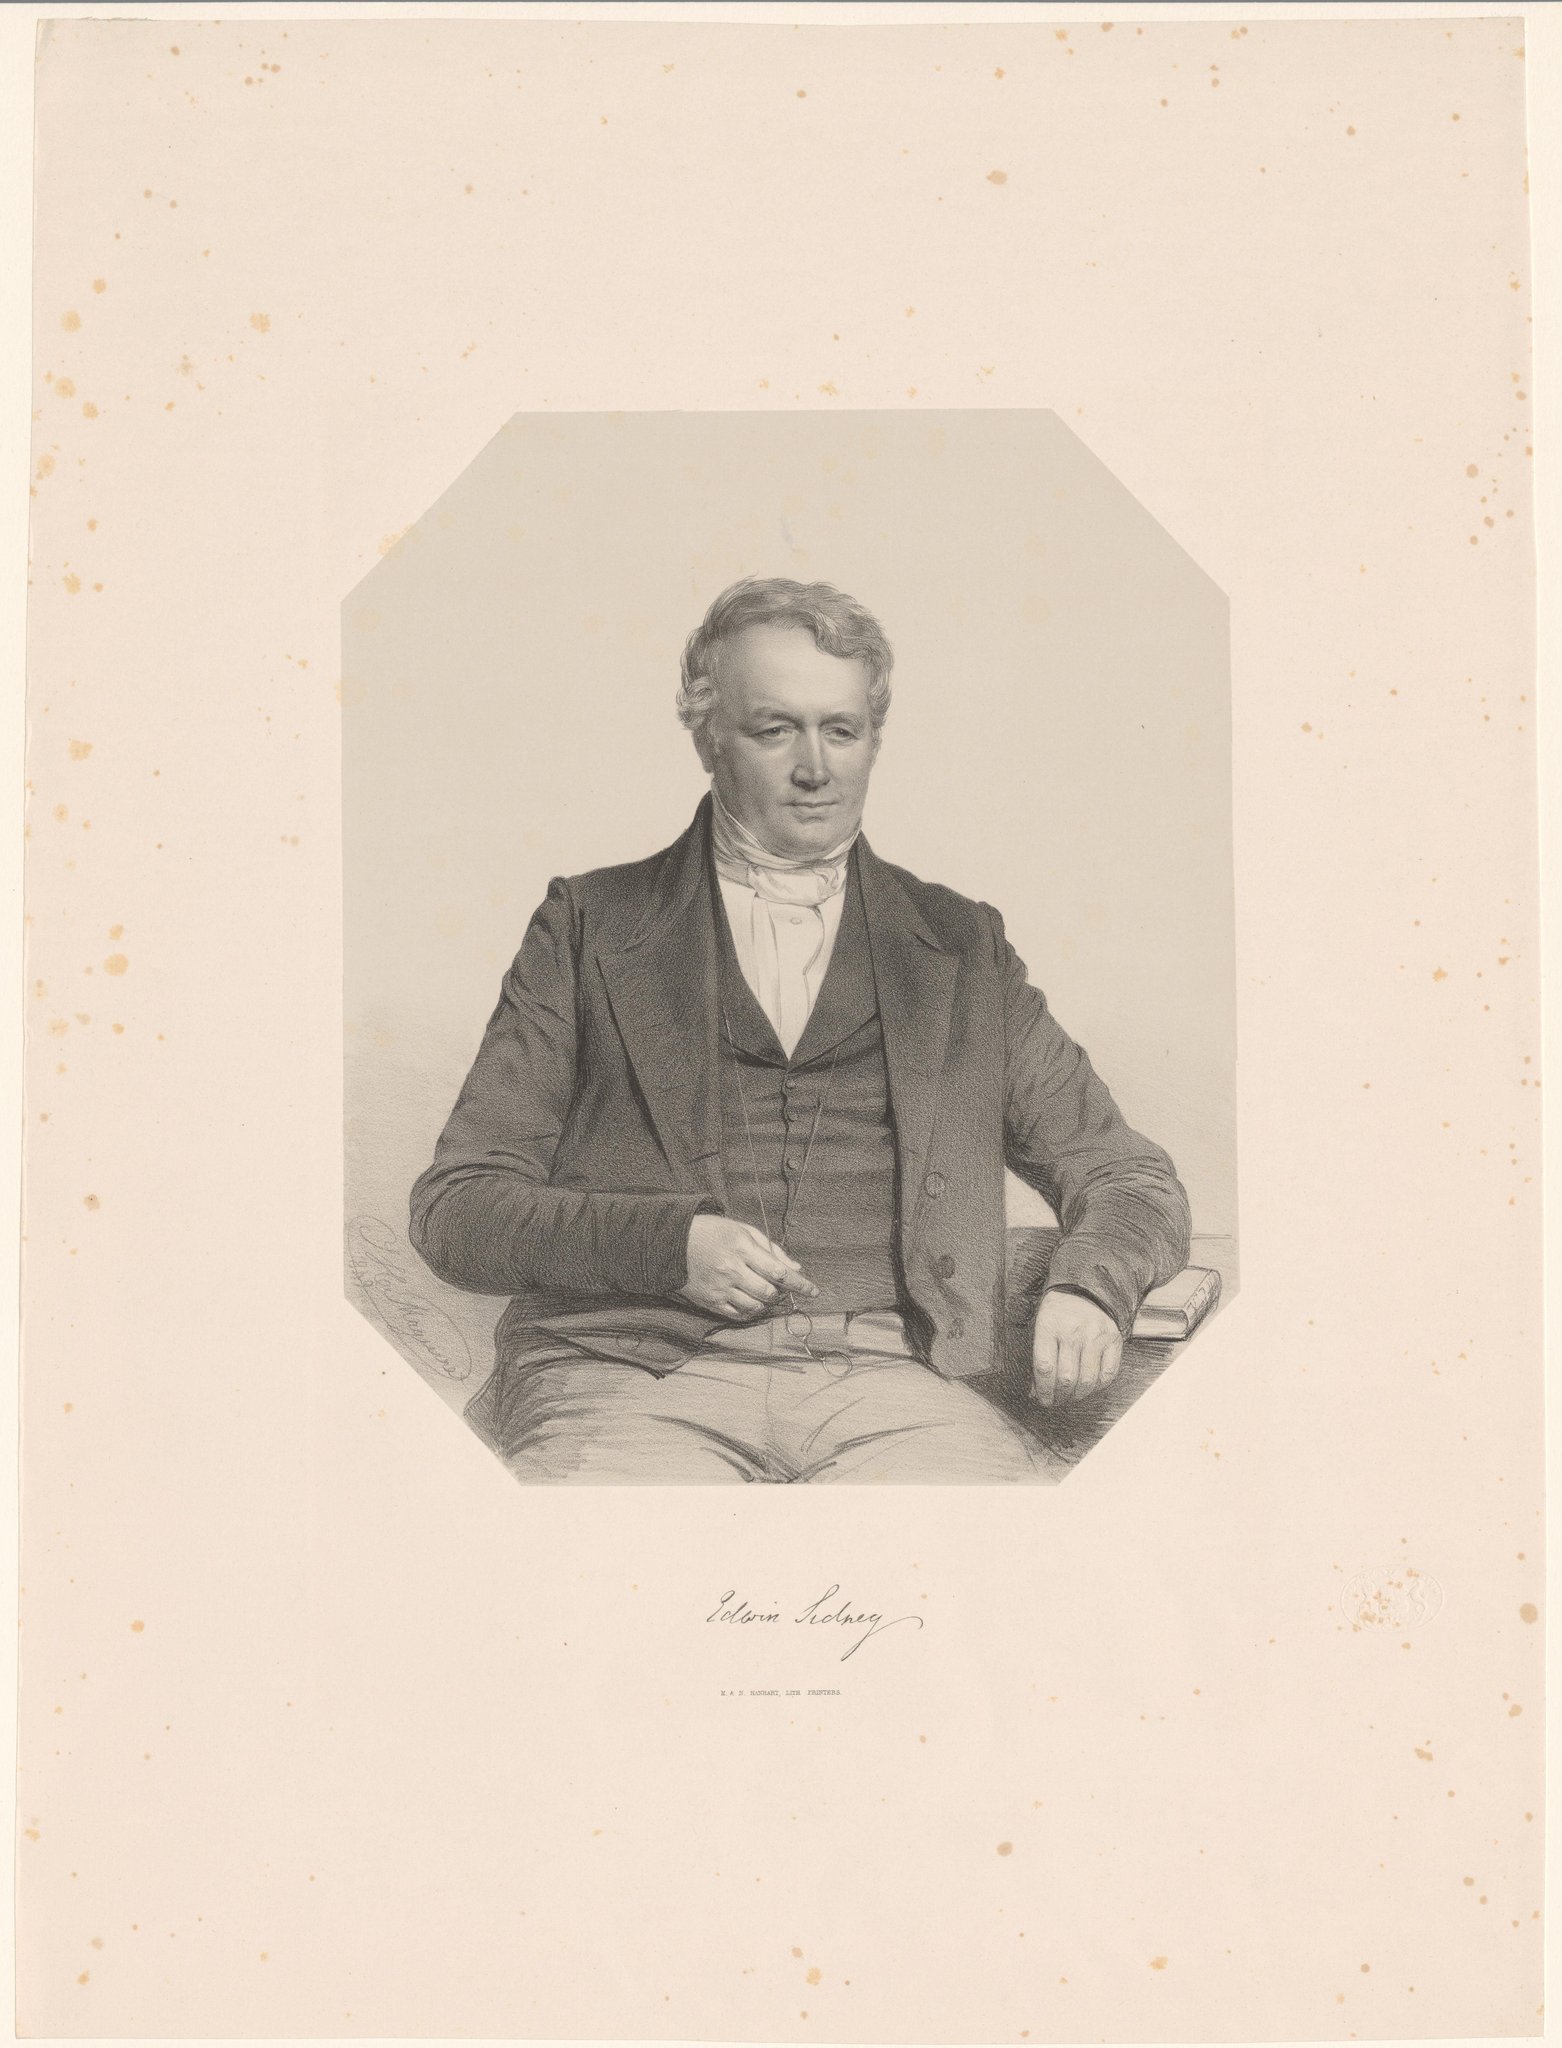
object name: print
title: Portret van Edwin Sidney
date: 1852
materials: paper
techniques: lithograph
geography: london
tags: eyeglasses, spectacles, adult man, historical persons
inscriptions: collector's mark: Lugt 2228, check stamp: ‘Ipswich Museum’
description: Prent behoort tot de serie 'Ipswich Museum Portraits', ook bekend onder de titel 'Portraits of Honorary Members of the Ipswich Museum'. Deze serie is in 1852 door George Ransome uitgegeven en gedrukt door M&N Hanhart tussen 1848 en 1852. De serie bestaat uit ca. 60 portretten.